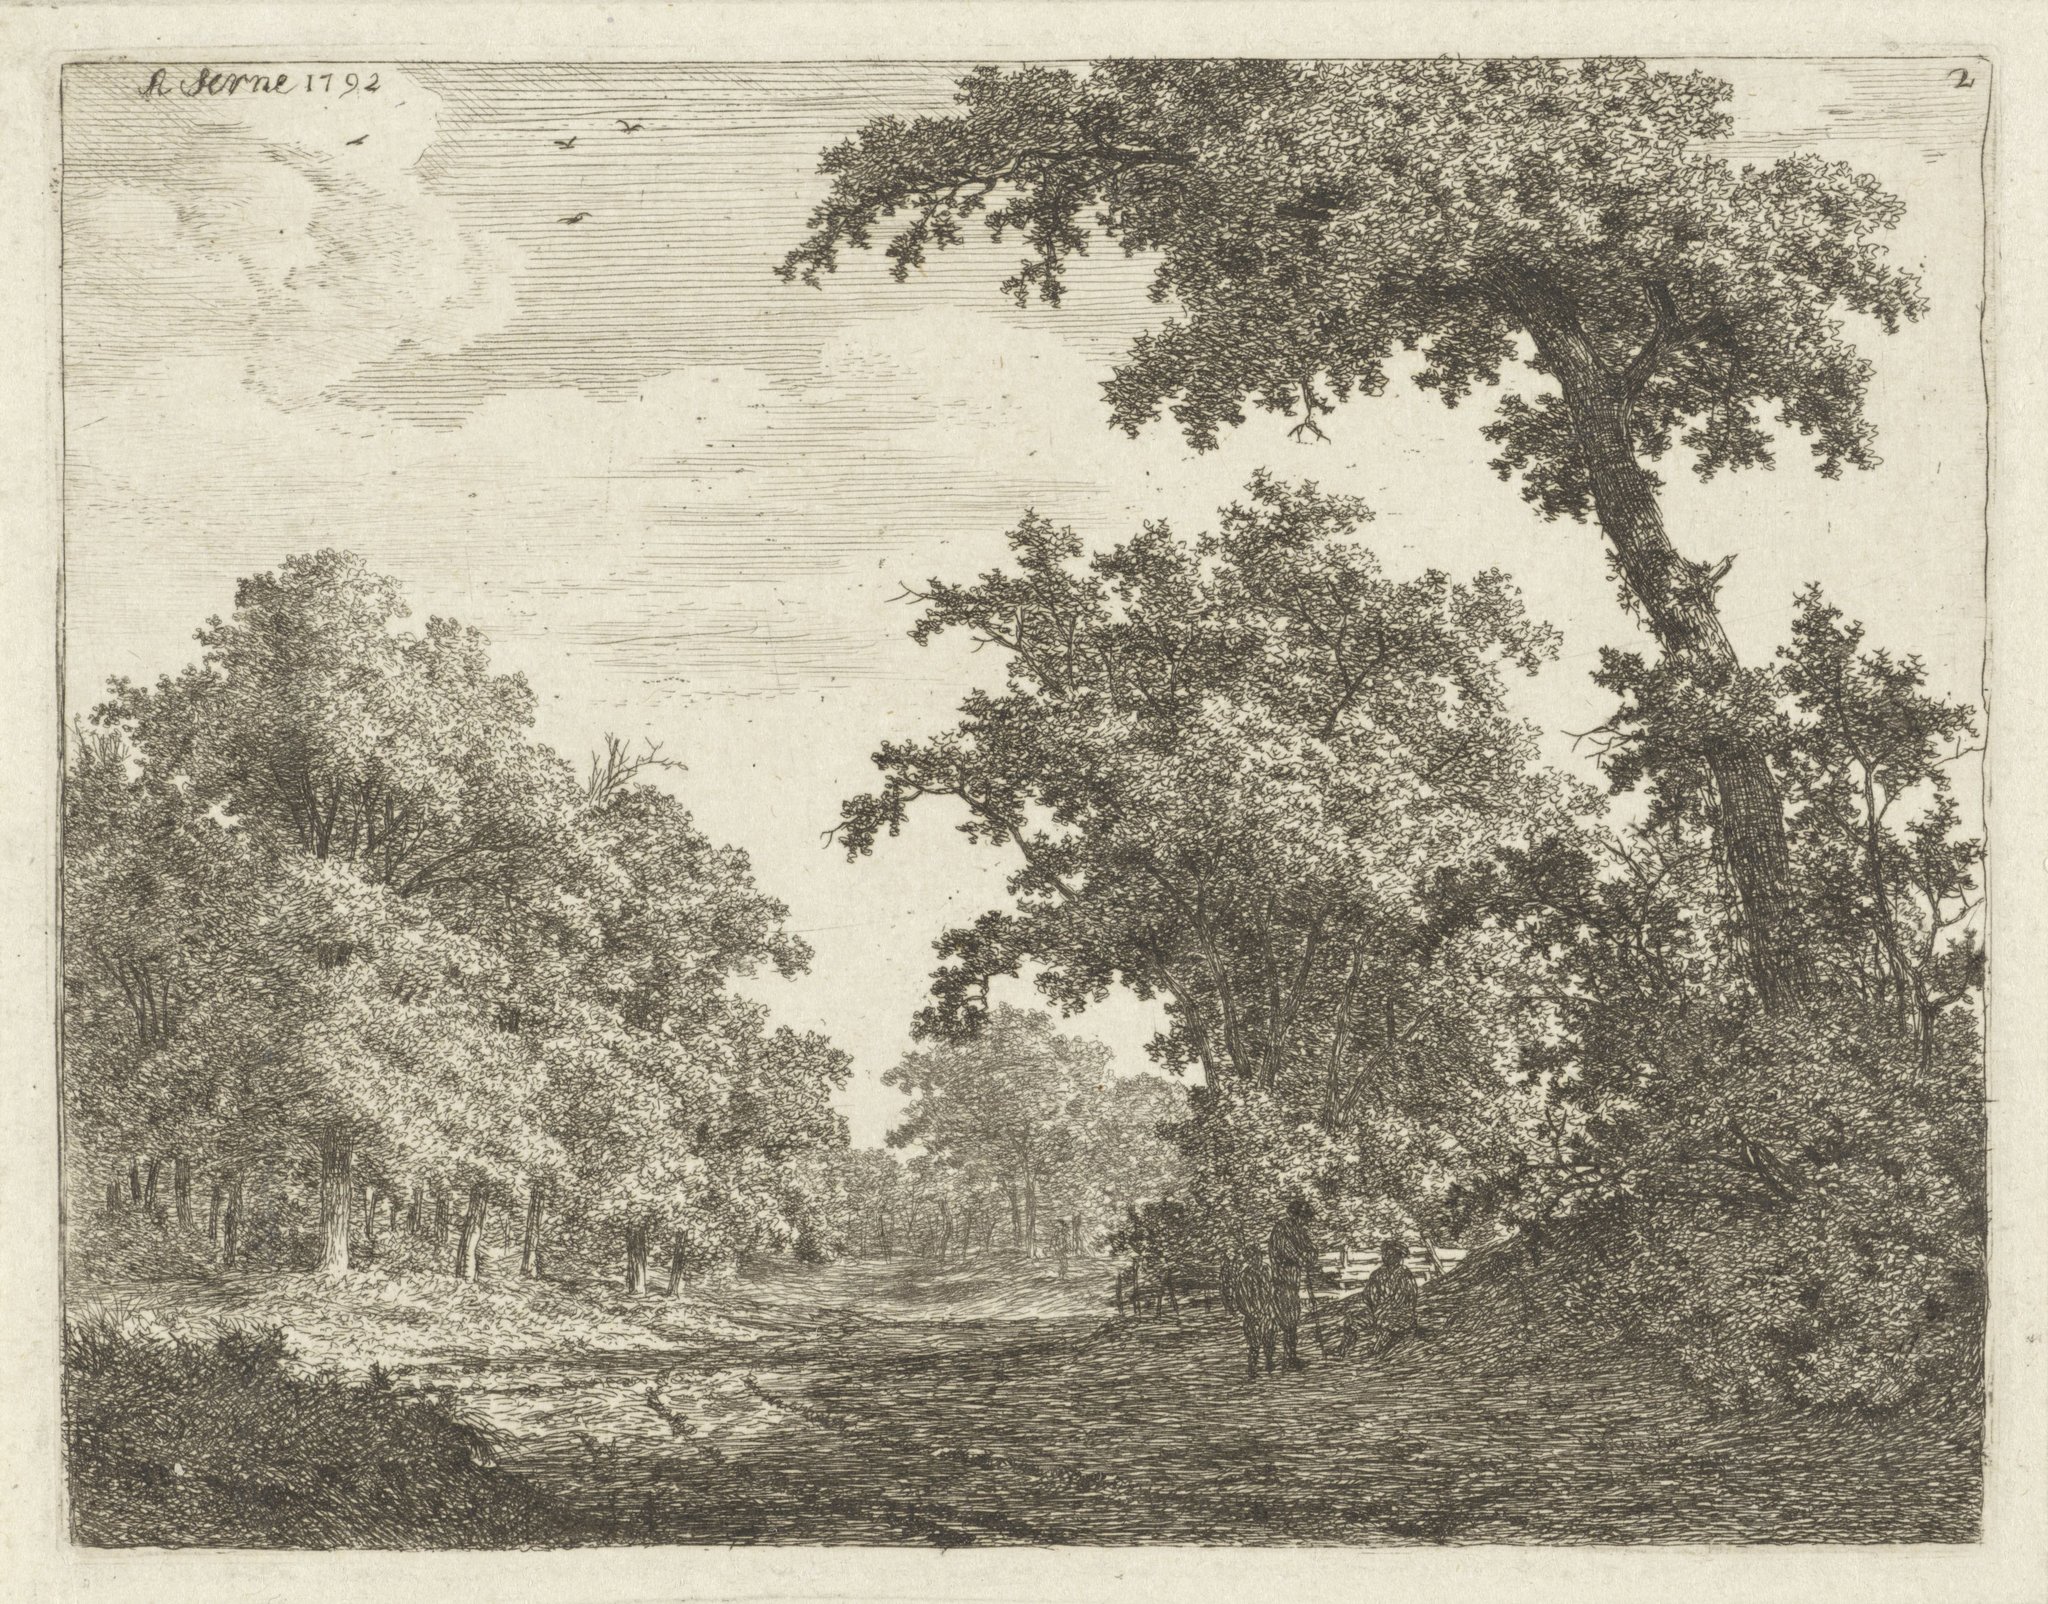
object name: print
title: Rustende reizigers langs een weg in het bos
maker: adrianus serné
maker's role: print maker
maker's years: 1773-1853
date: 1792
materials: paper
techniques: etching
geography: haarlem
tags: public road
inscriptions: collector's mark: Lugt 2228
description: Rustende reizigers langs een weg in het bos. Rechtsboven genummerd: 2.